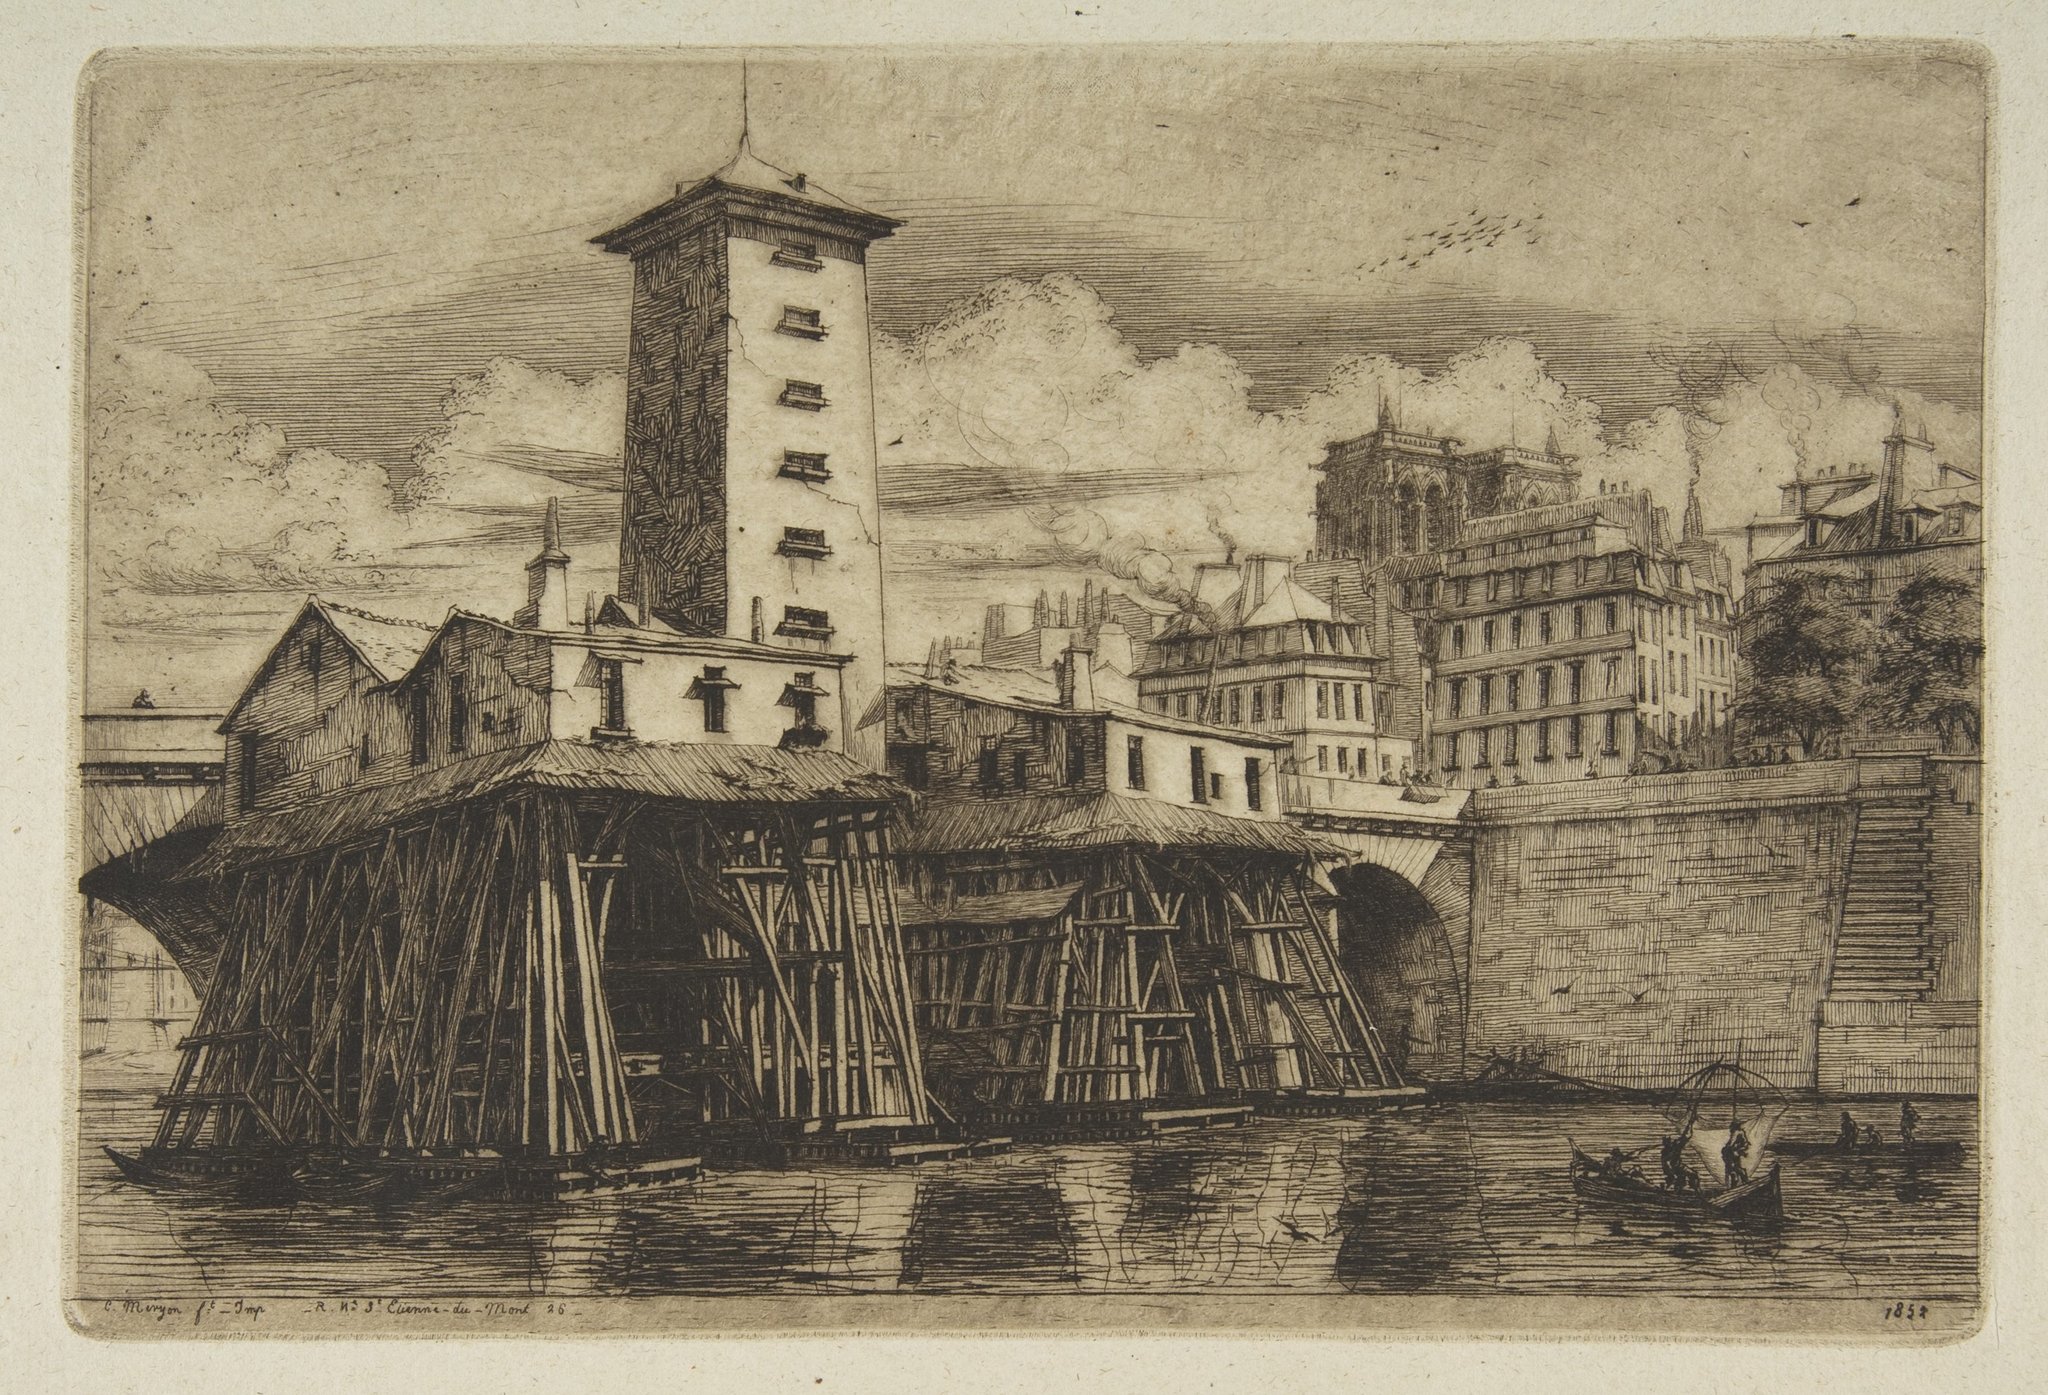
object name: print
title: The Nôtre-Dame Pump, from "Etchings of Paris"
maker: charles meryon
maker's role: artist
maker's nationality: french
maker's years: 1821-1868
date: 1852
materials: paper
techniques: etching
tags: buildings,boats,paris